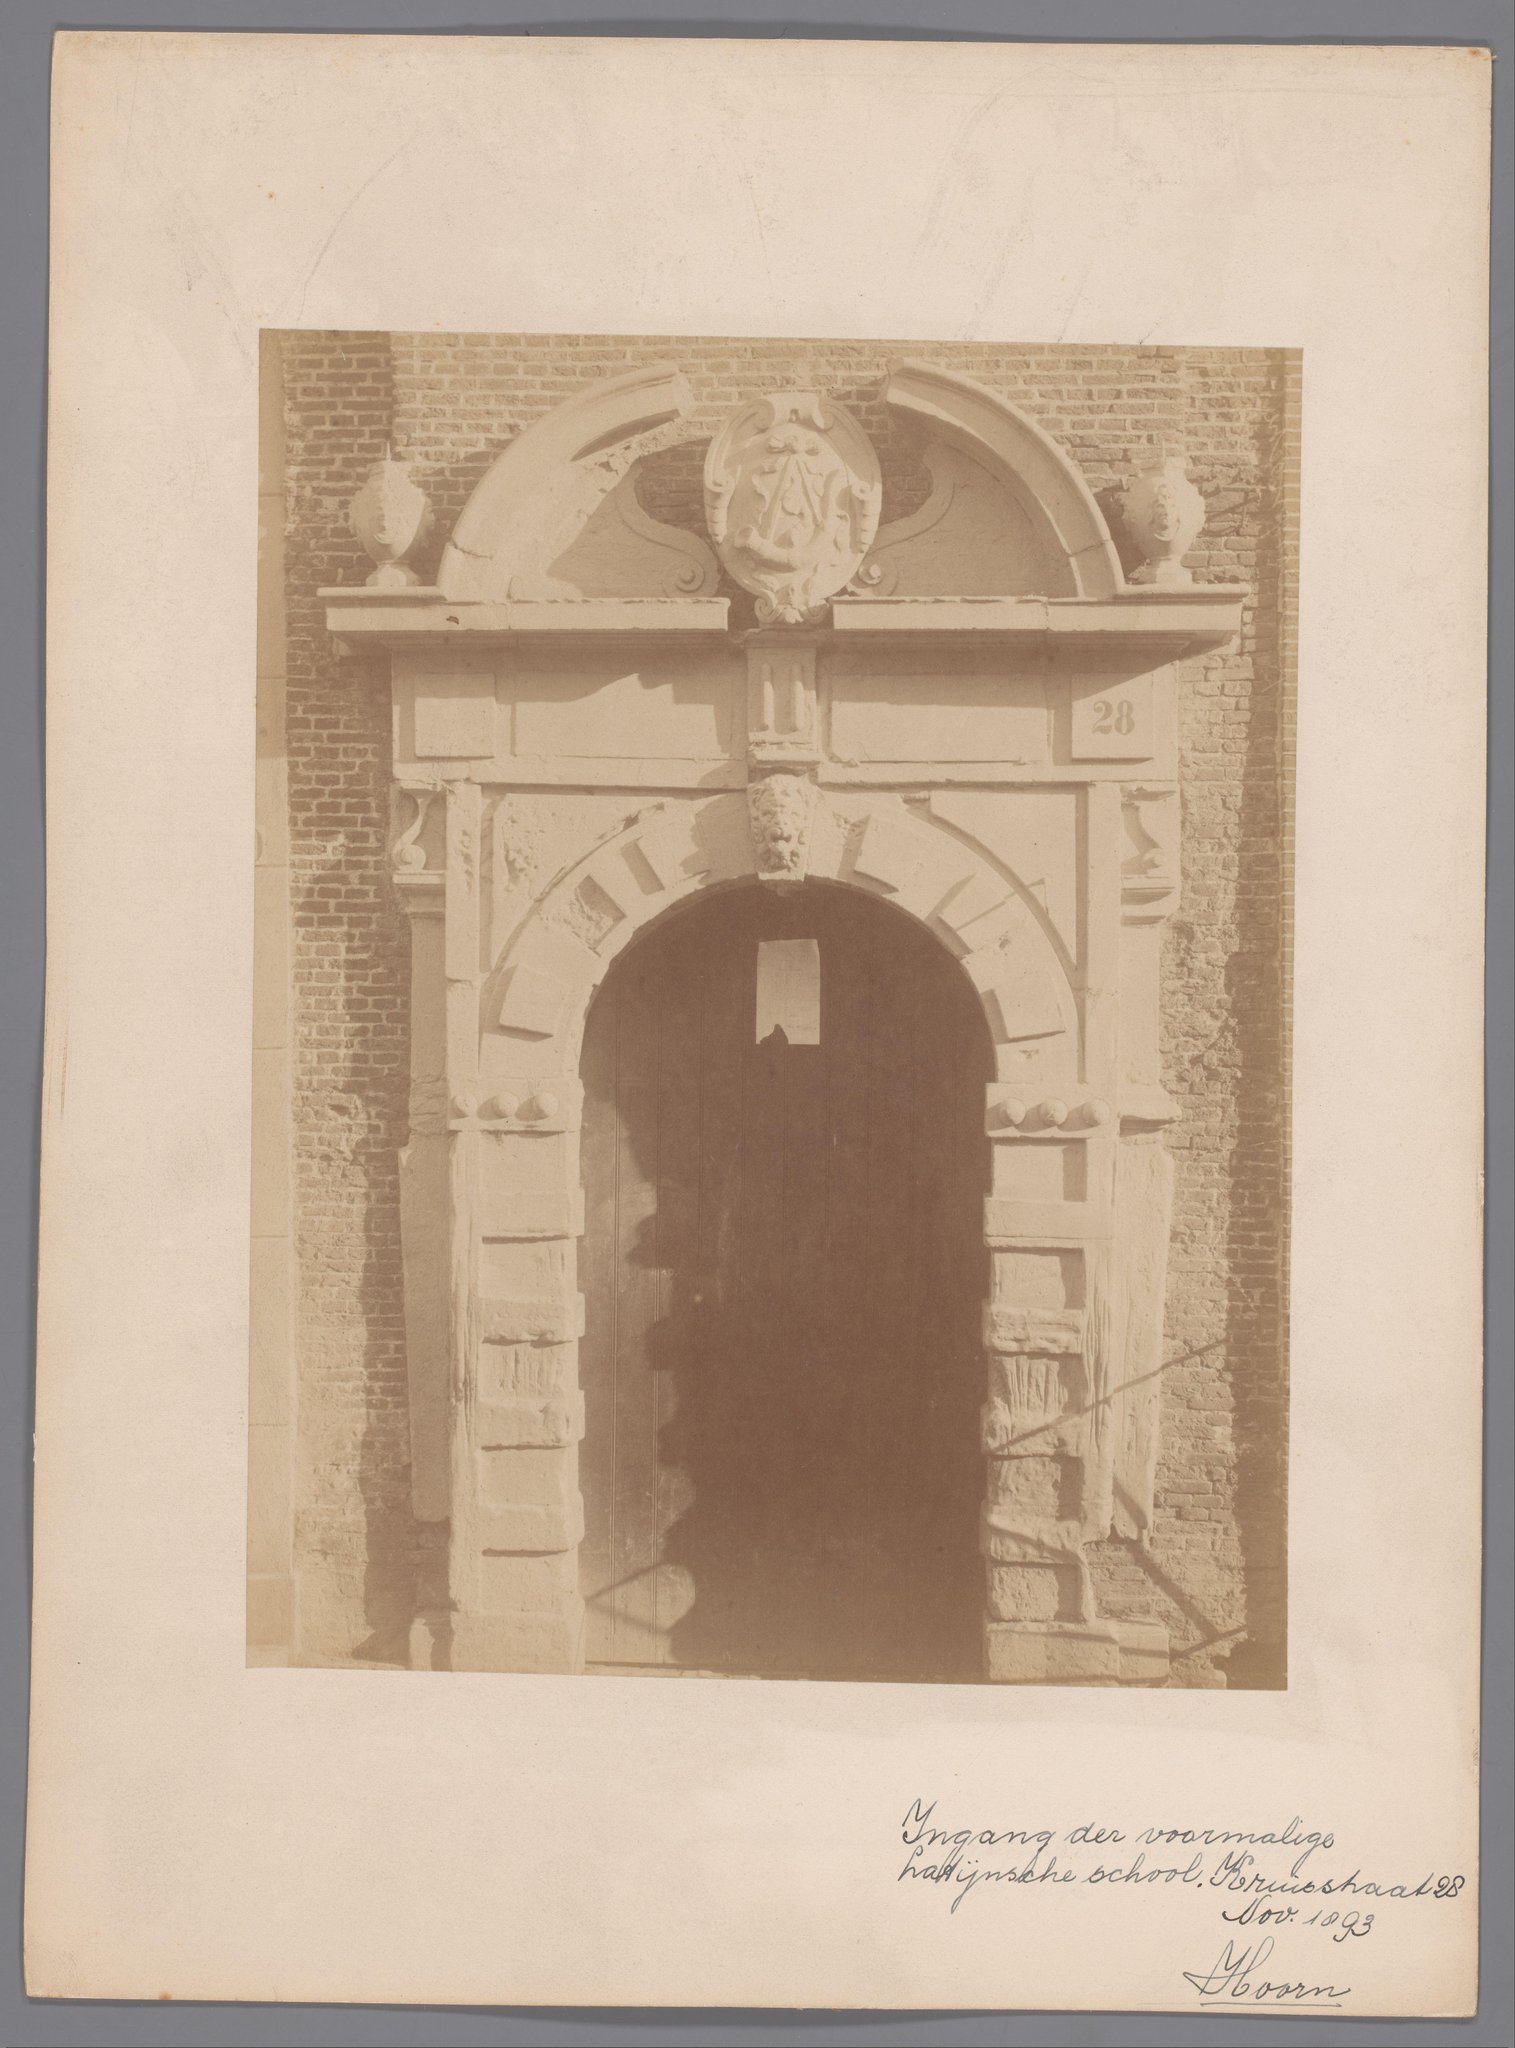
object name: photograph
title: Ingang van de voormalige Latijnse School op Kruisstraat 28 te Hoorn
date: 1893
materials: cardboard, photographic support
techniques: albumen print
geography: kruisstraat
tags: gate, entrance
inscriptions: annotation: ‘Hoorn (N.H.)/ Ingang der voormalige latijnsche school/ Kruisstraat 28/ Nov. 1893’, annotation: ‘Ingang der voormalige Latijnsche school. Kruisstraat 28/ Nov. 1893/ Hoorn’